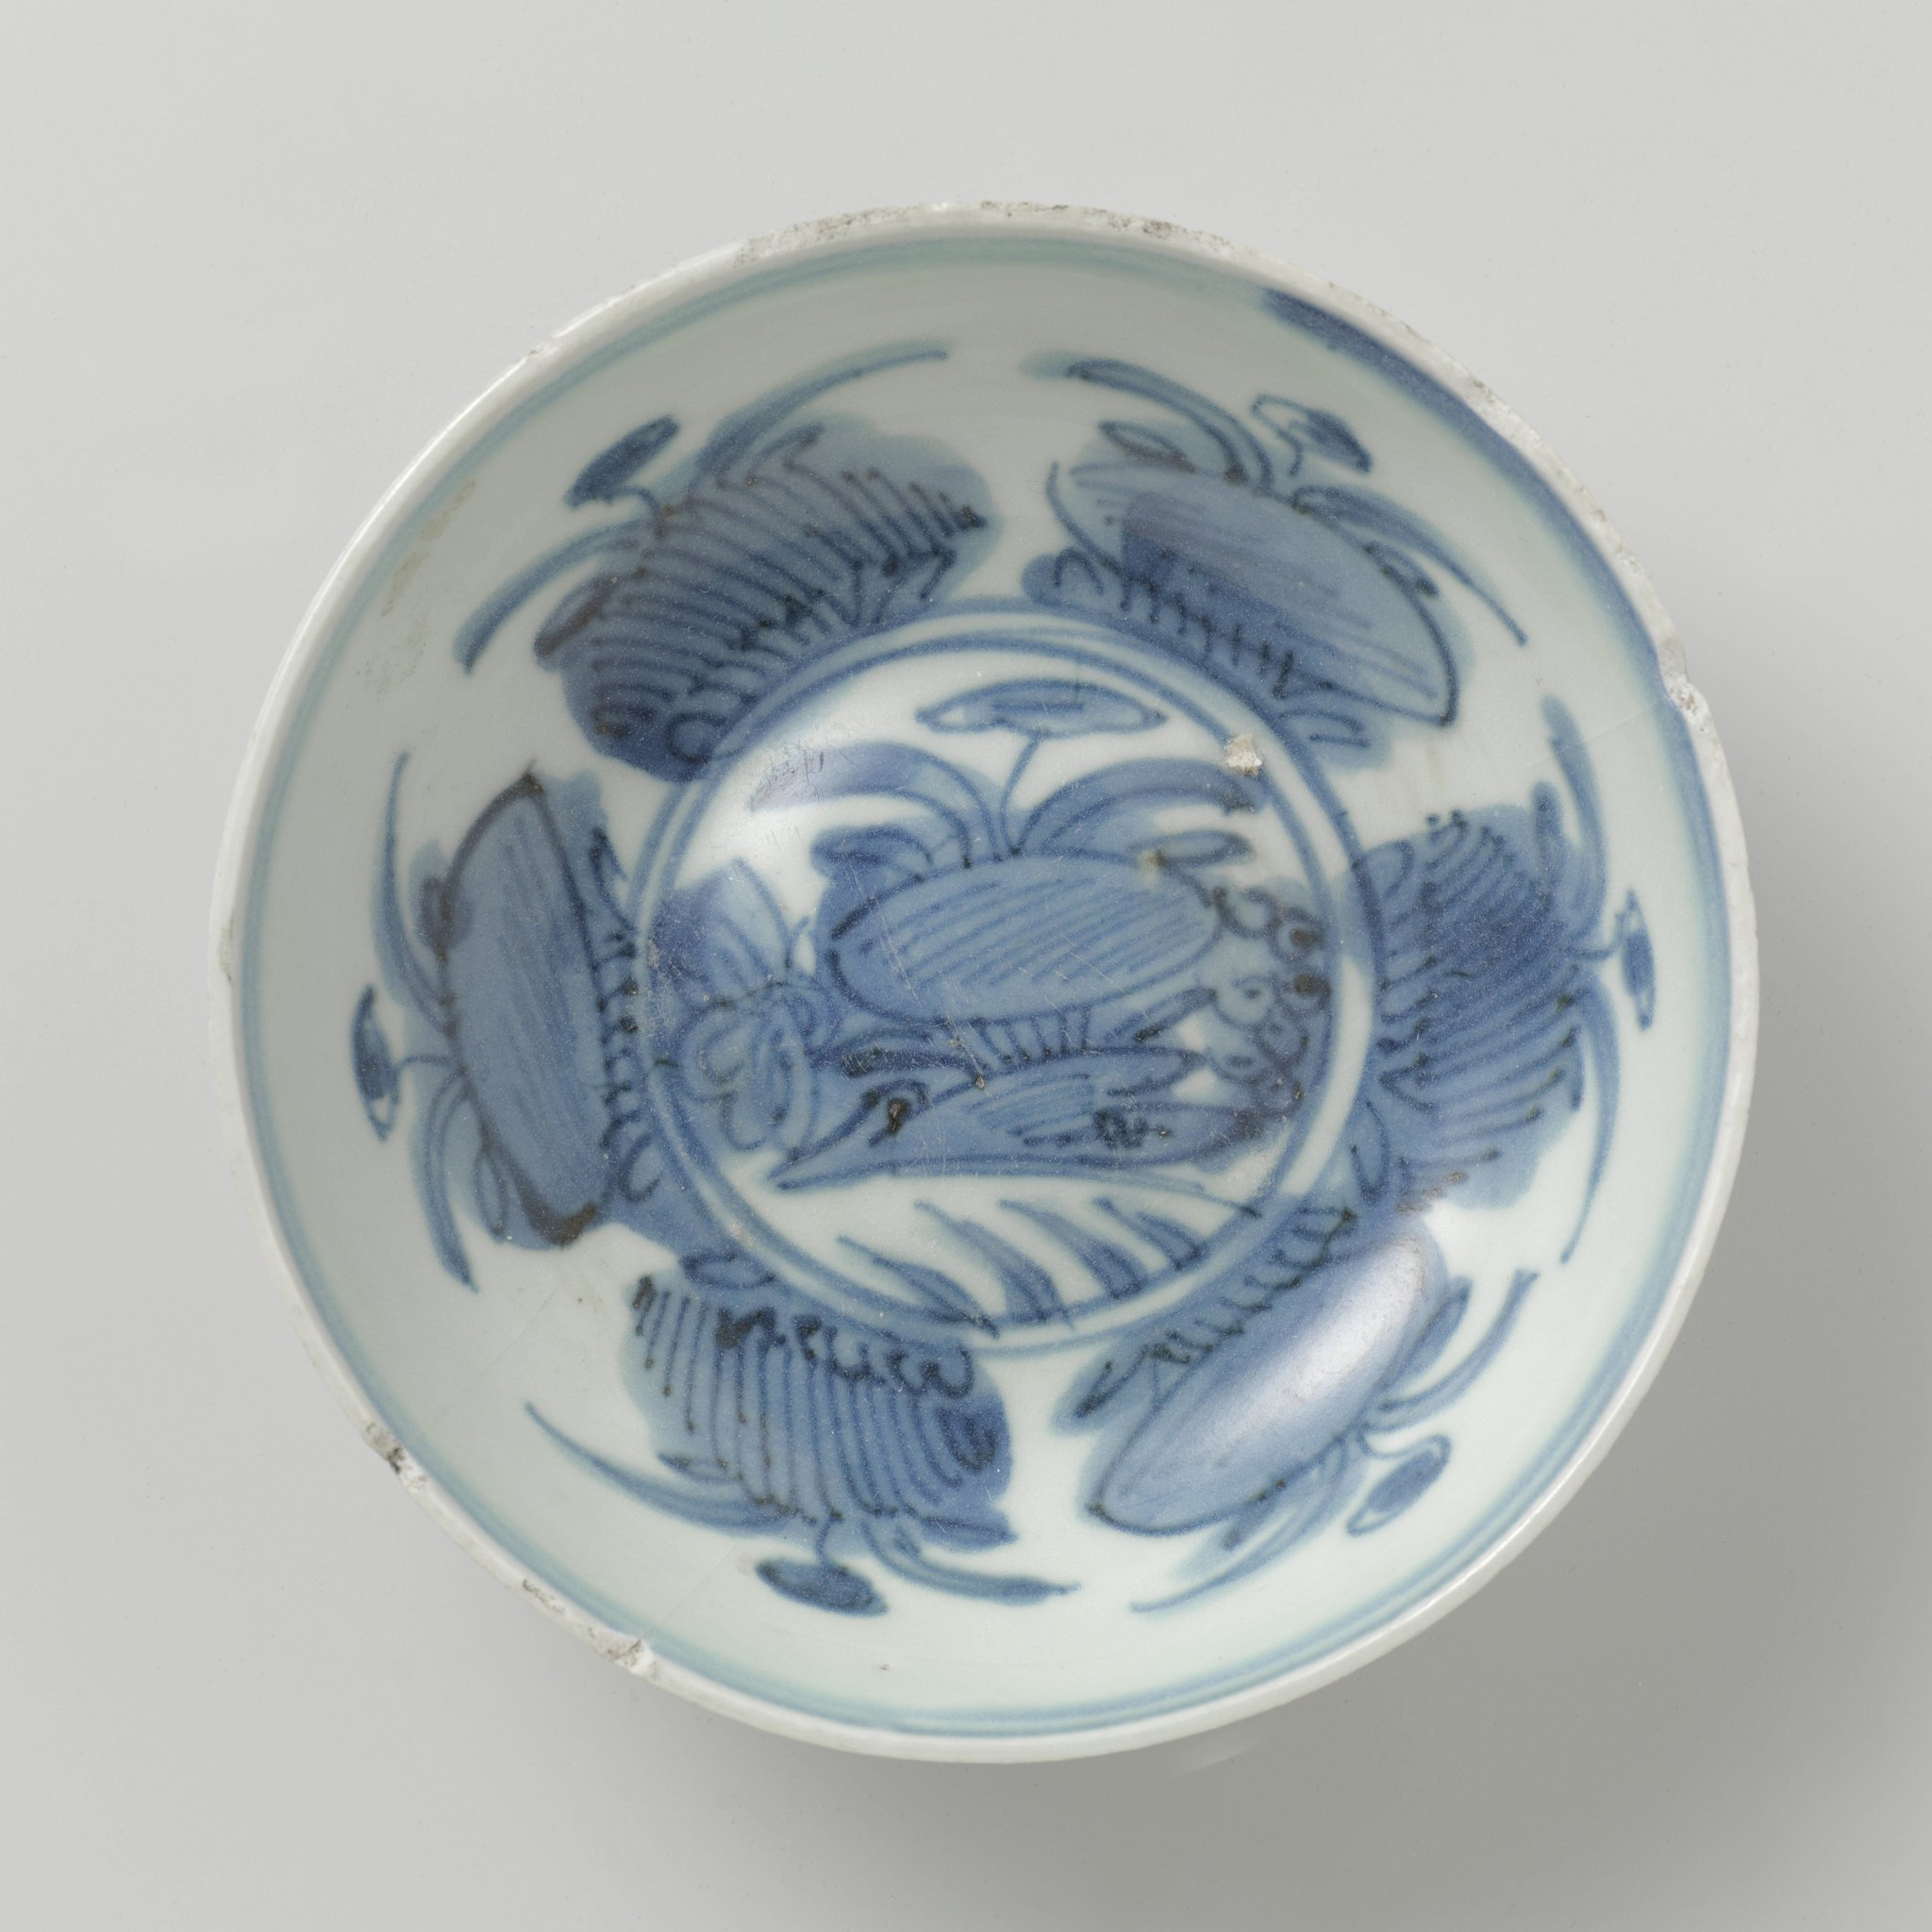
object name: platter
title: Schotel uit V.O.C.-schip de 'Witte Leeuw'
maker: Anonymous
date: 1613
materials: porcelain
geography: jingdezhen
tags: lotus ~ ornament - aa - stylized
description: A saucer. The decoration on the inside consists of a flowering lotus plant with a duck underneath in the centre. On the cavetto 6 similar lotus plants are drawn.